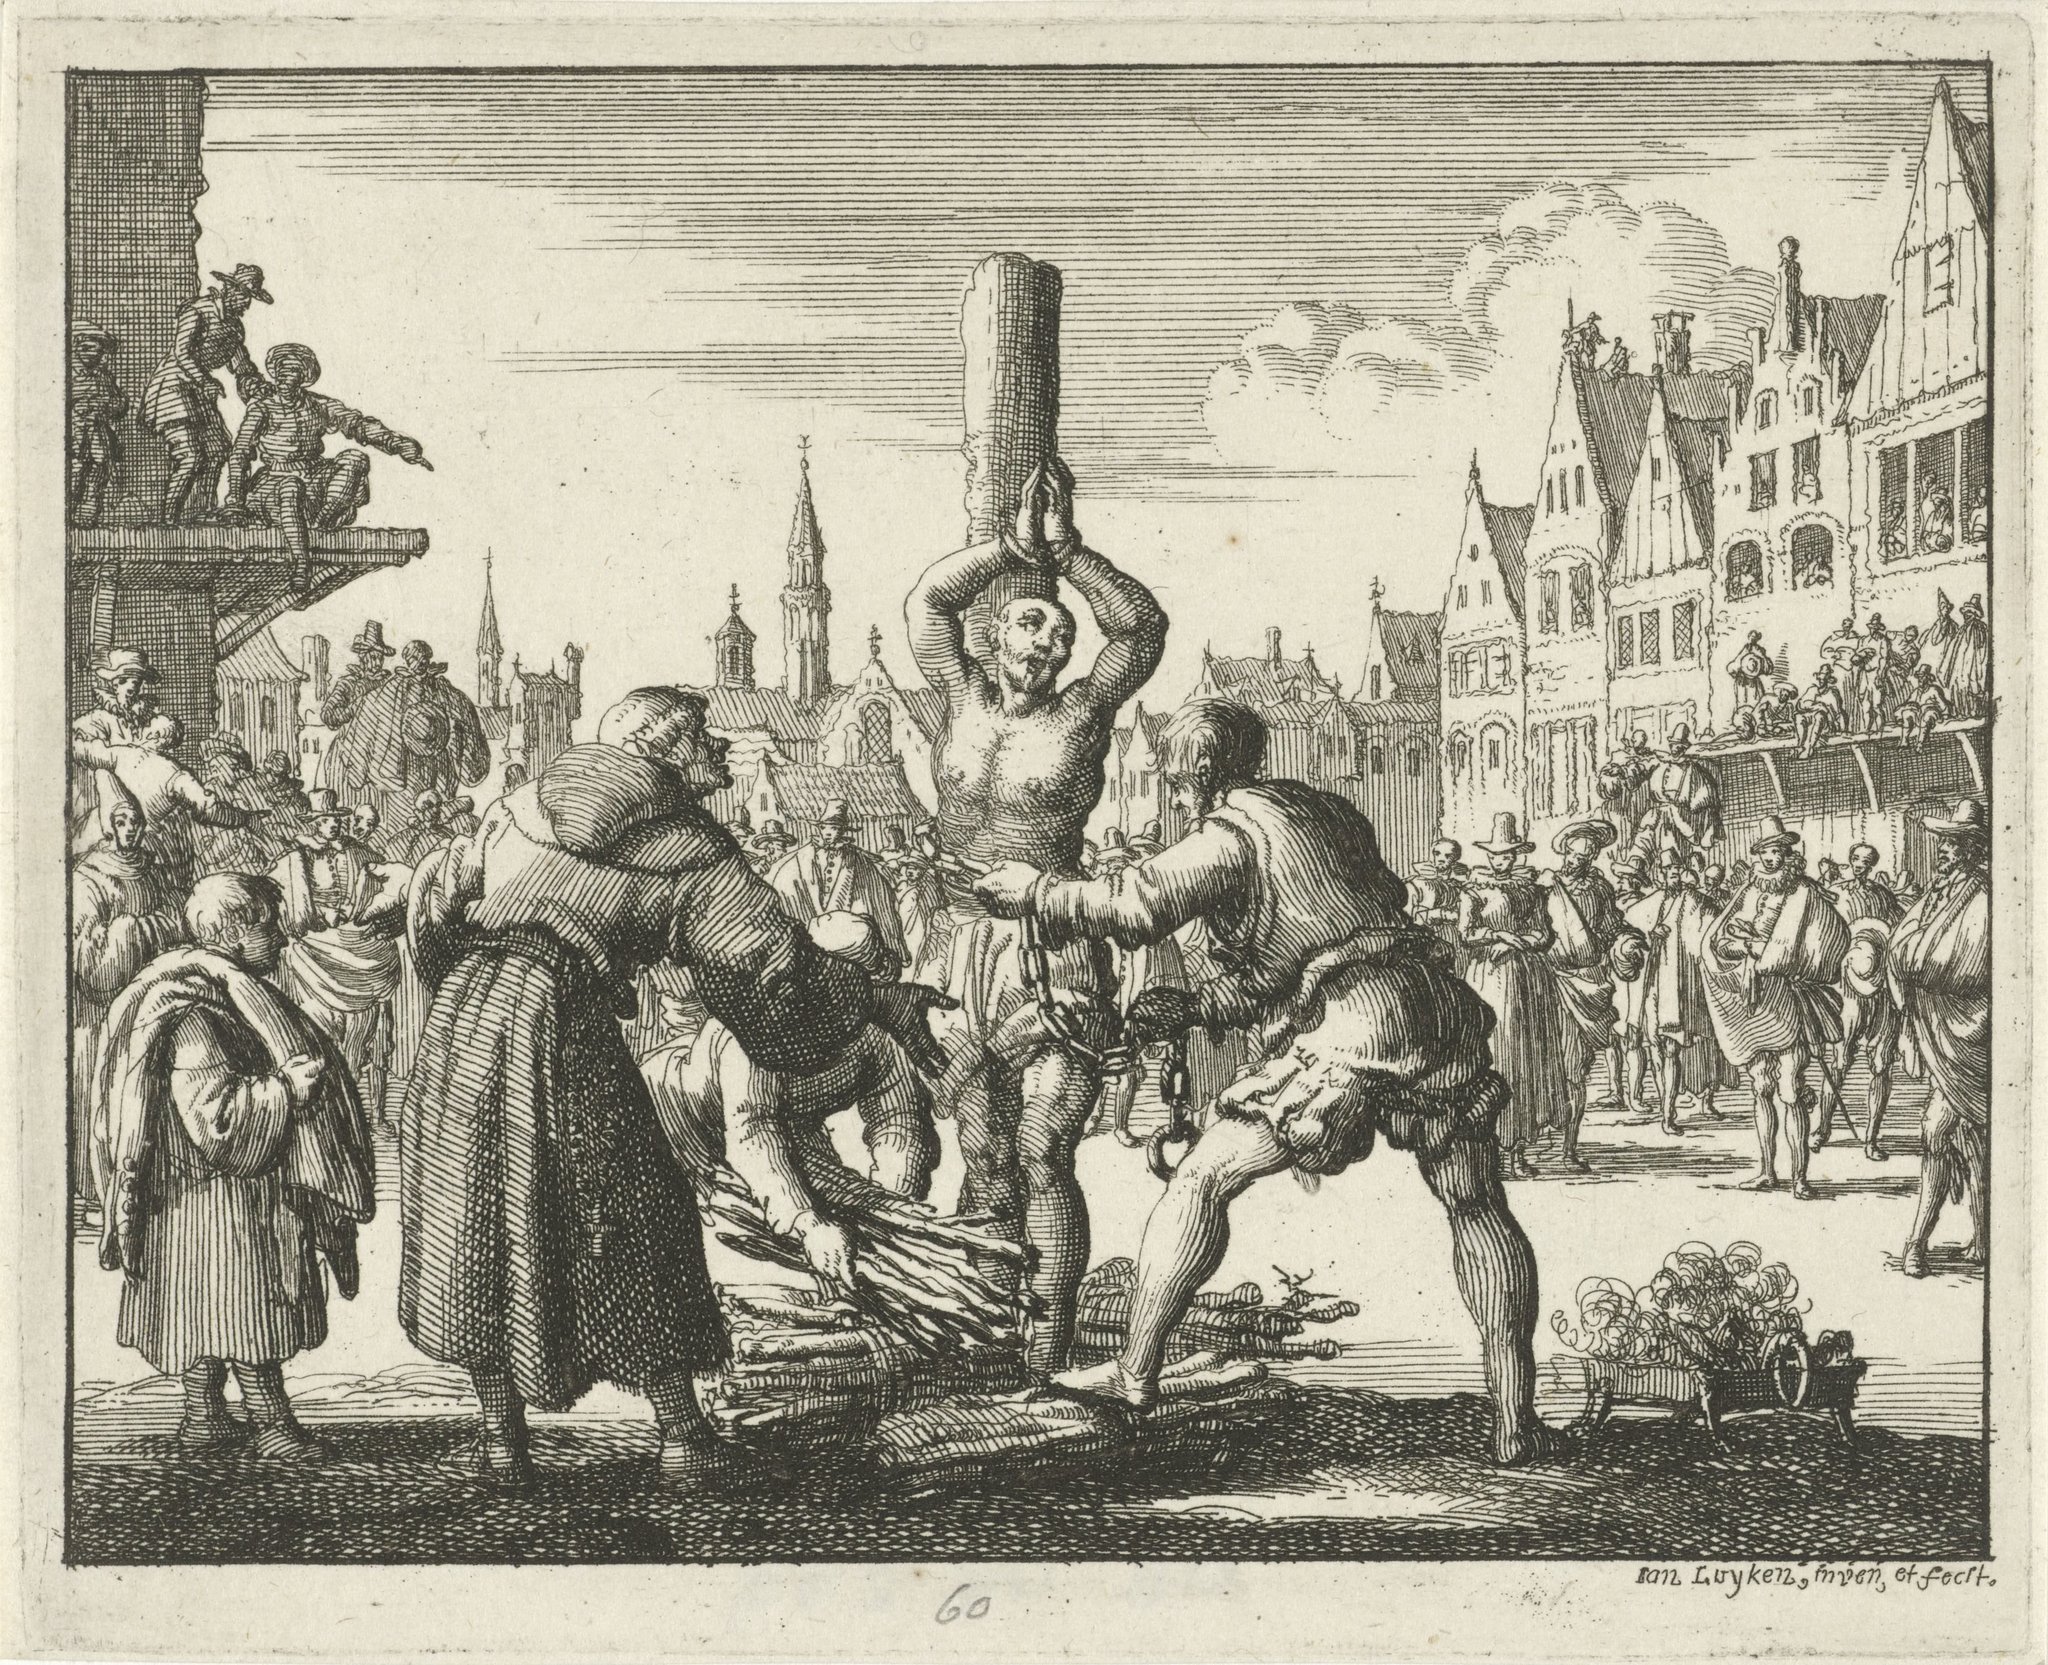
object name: print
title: Johan Knel op de brandstapel in Londen, 1550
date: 1685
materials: paper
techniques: etching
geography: amsterdam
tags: execution of heretic, e.g. by burning at the stake, 'auto-da-fé', london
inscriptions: collector's mark: Lugt 2228, number: ‘60’